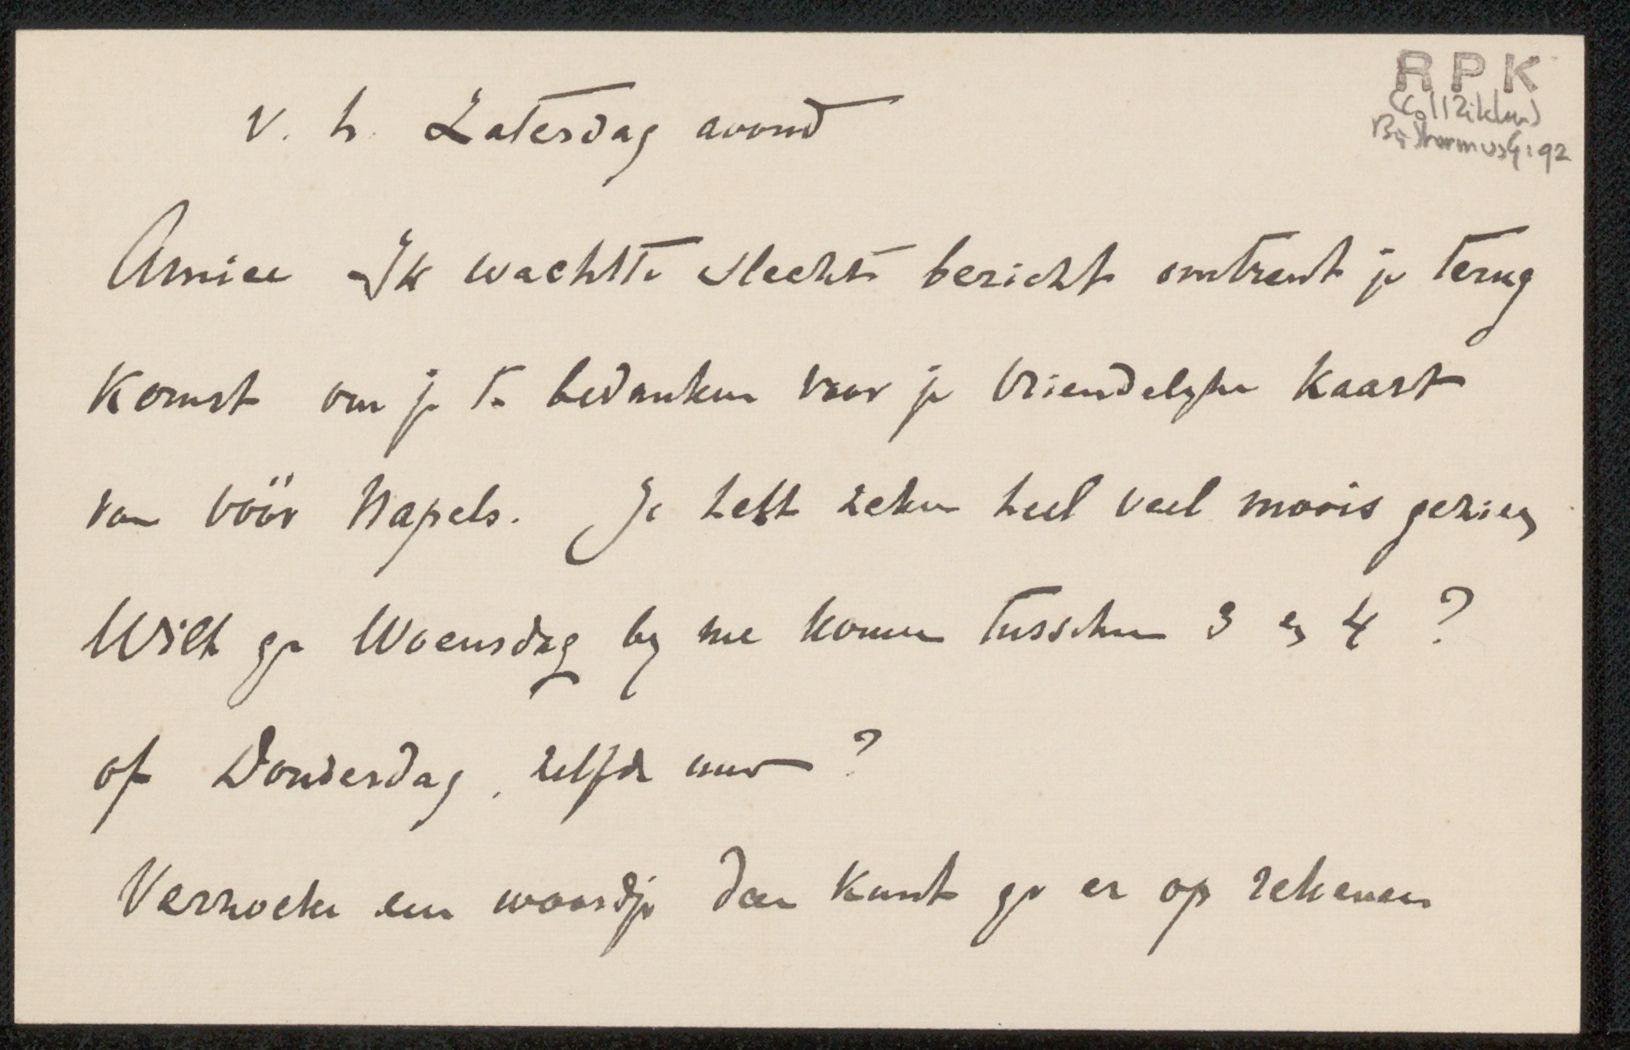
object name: letter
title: Brief aan Philip Zilcken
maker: carel nicolaas storm van s-gravesande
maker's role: draughtsman, print maker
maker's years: 1841-1924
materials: cardboard, ink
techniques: pen, writing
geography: the hague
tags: the hague, painter, draughtsman, philip zilcken, naples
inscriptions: collector's mark: ‘RPK’